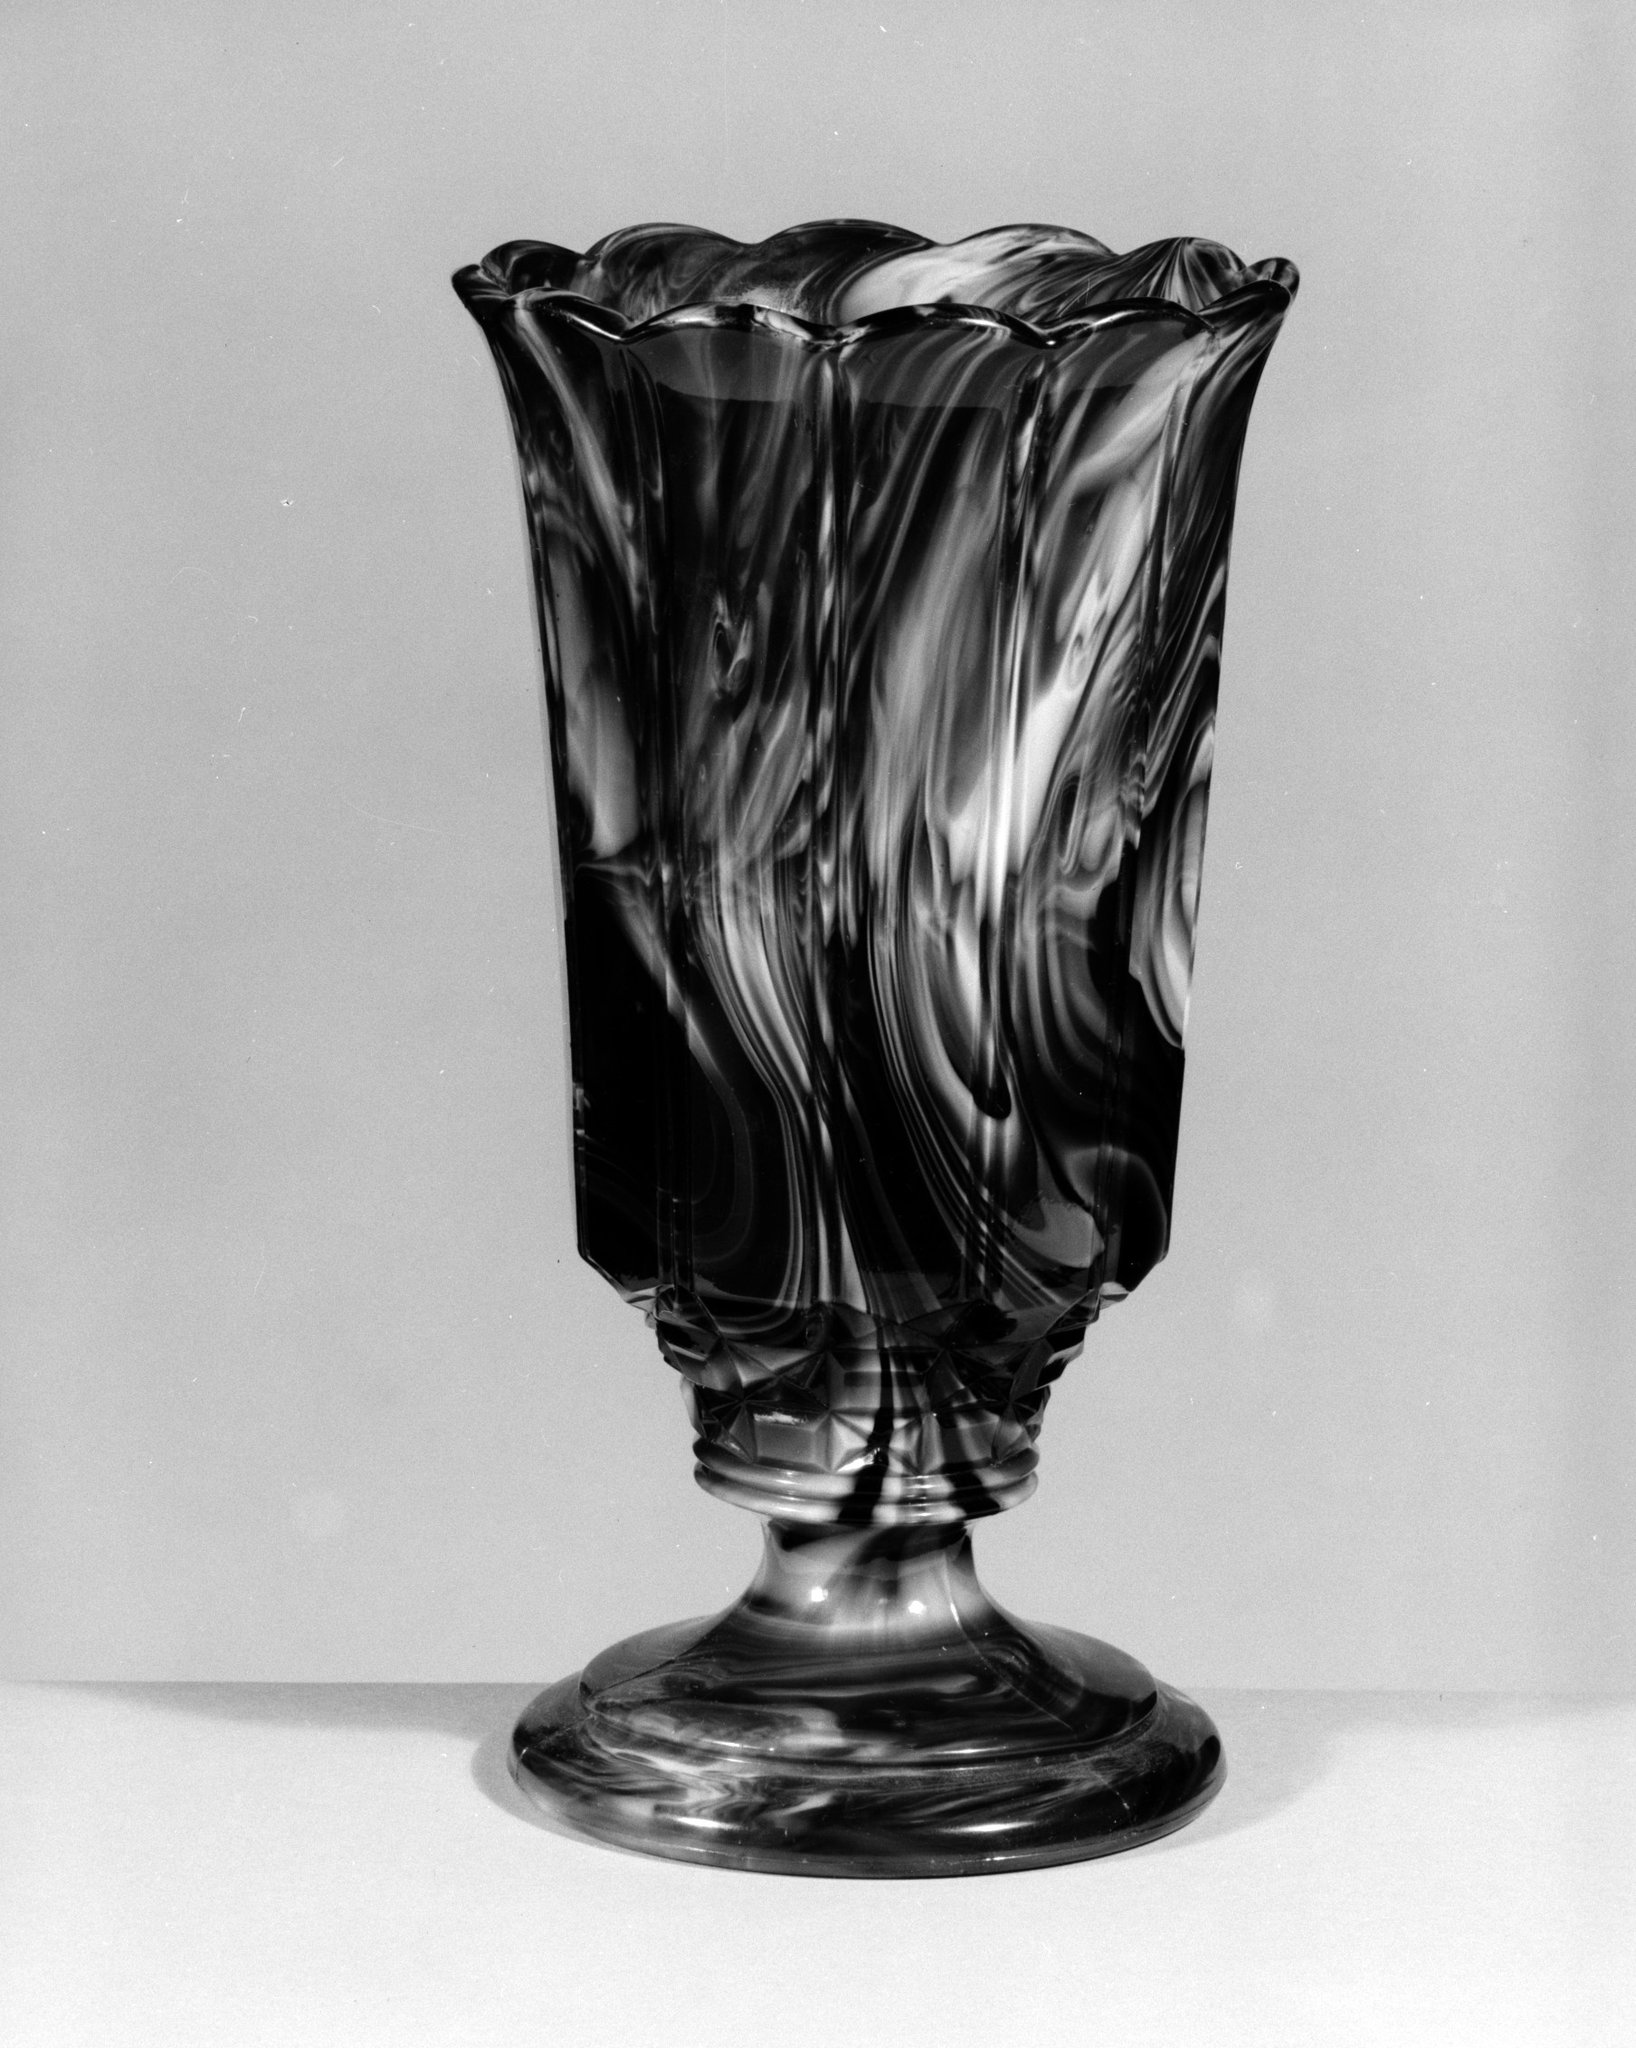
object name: celery vase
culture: american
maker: challinor, taylor and company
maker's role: maker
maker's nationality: american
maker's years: 1866-1891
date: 1870-1890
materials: glass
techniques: pressed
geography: united states